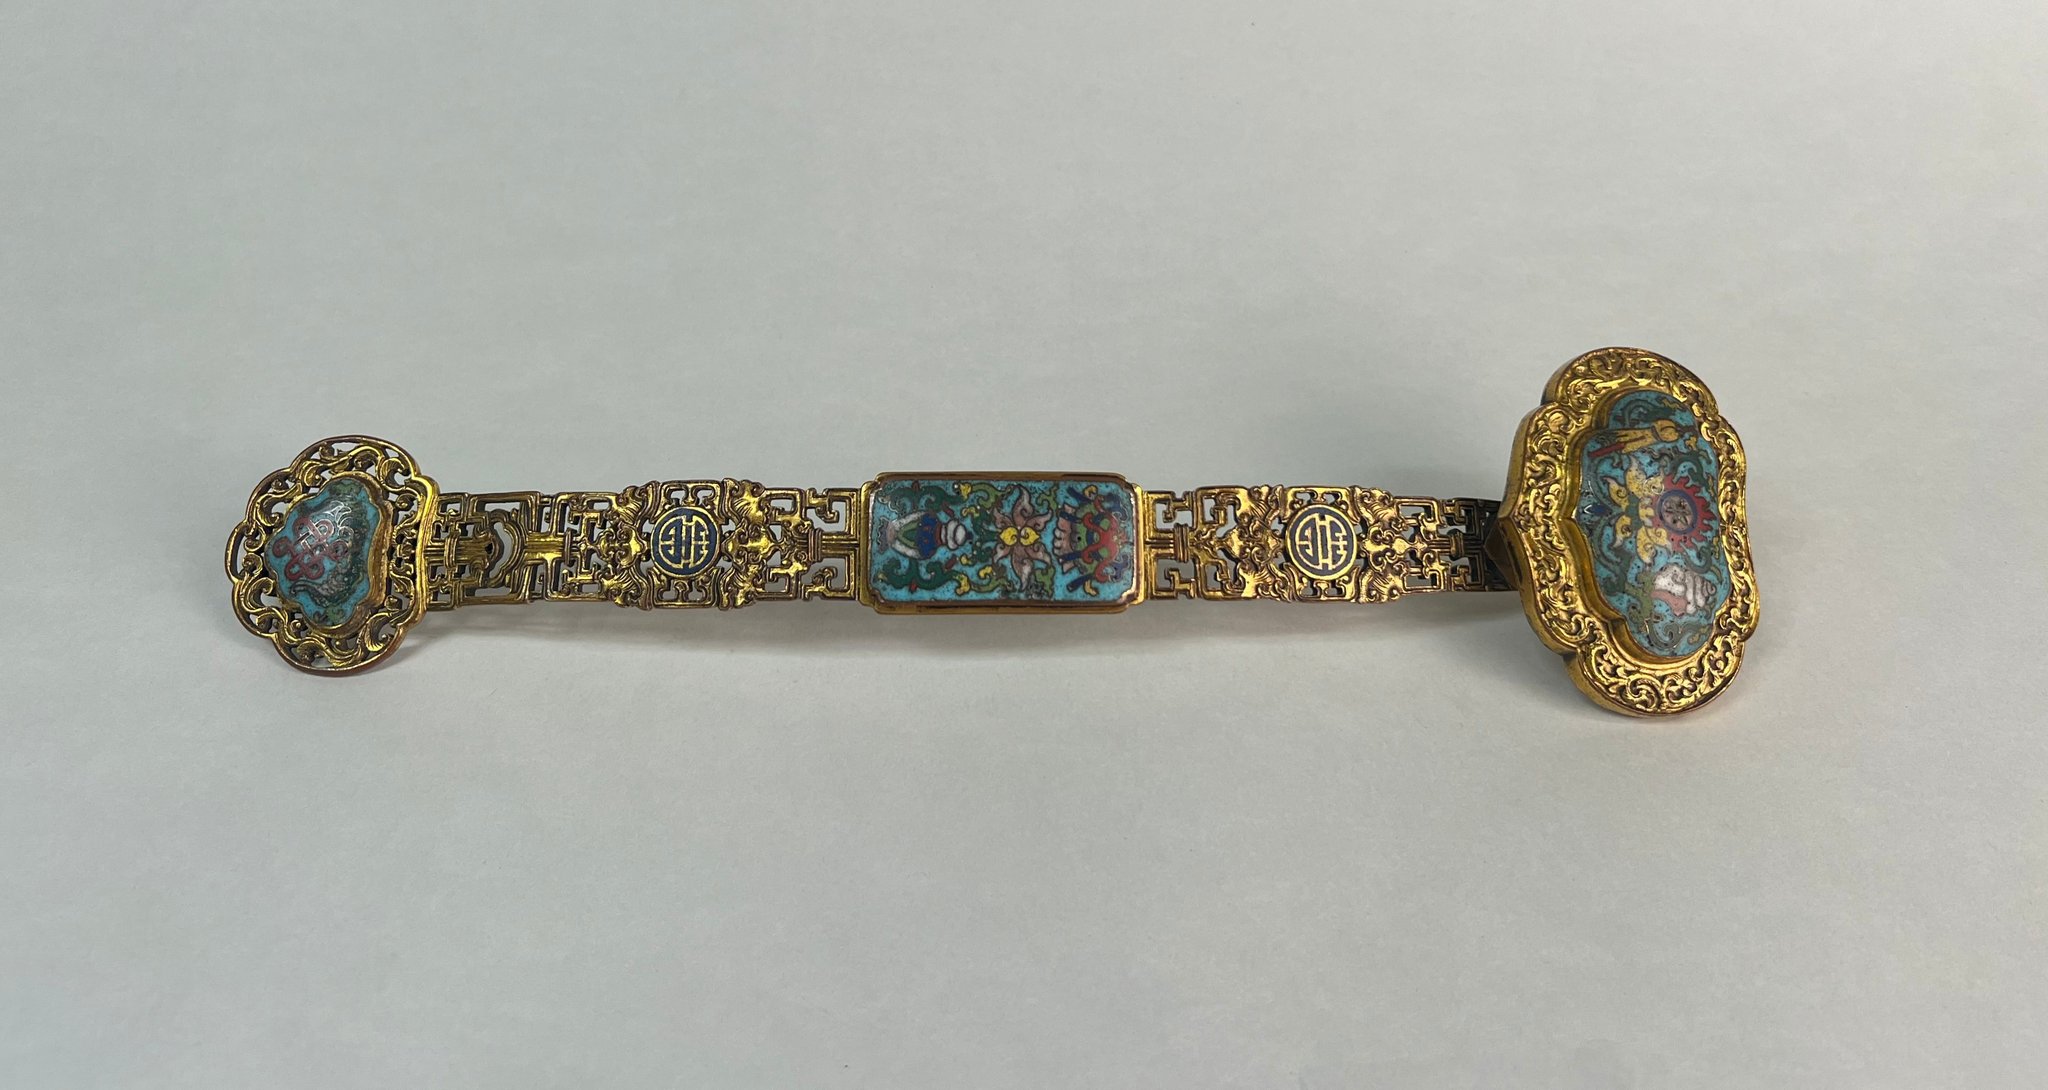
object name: ruyi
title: Ruyi (A Type of Decorative Accessory)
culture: chinese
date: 1701-1800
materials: enamel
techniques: enamel